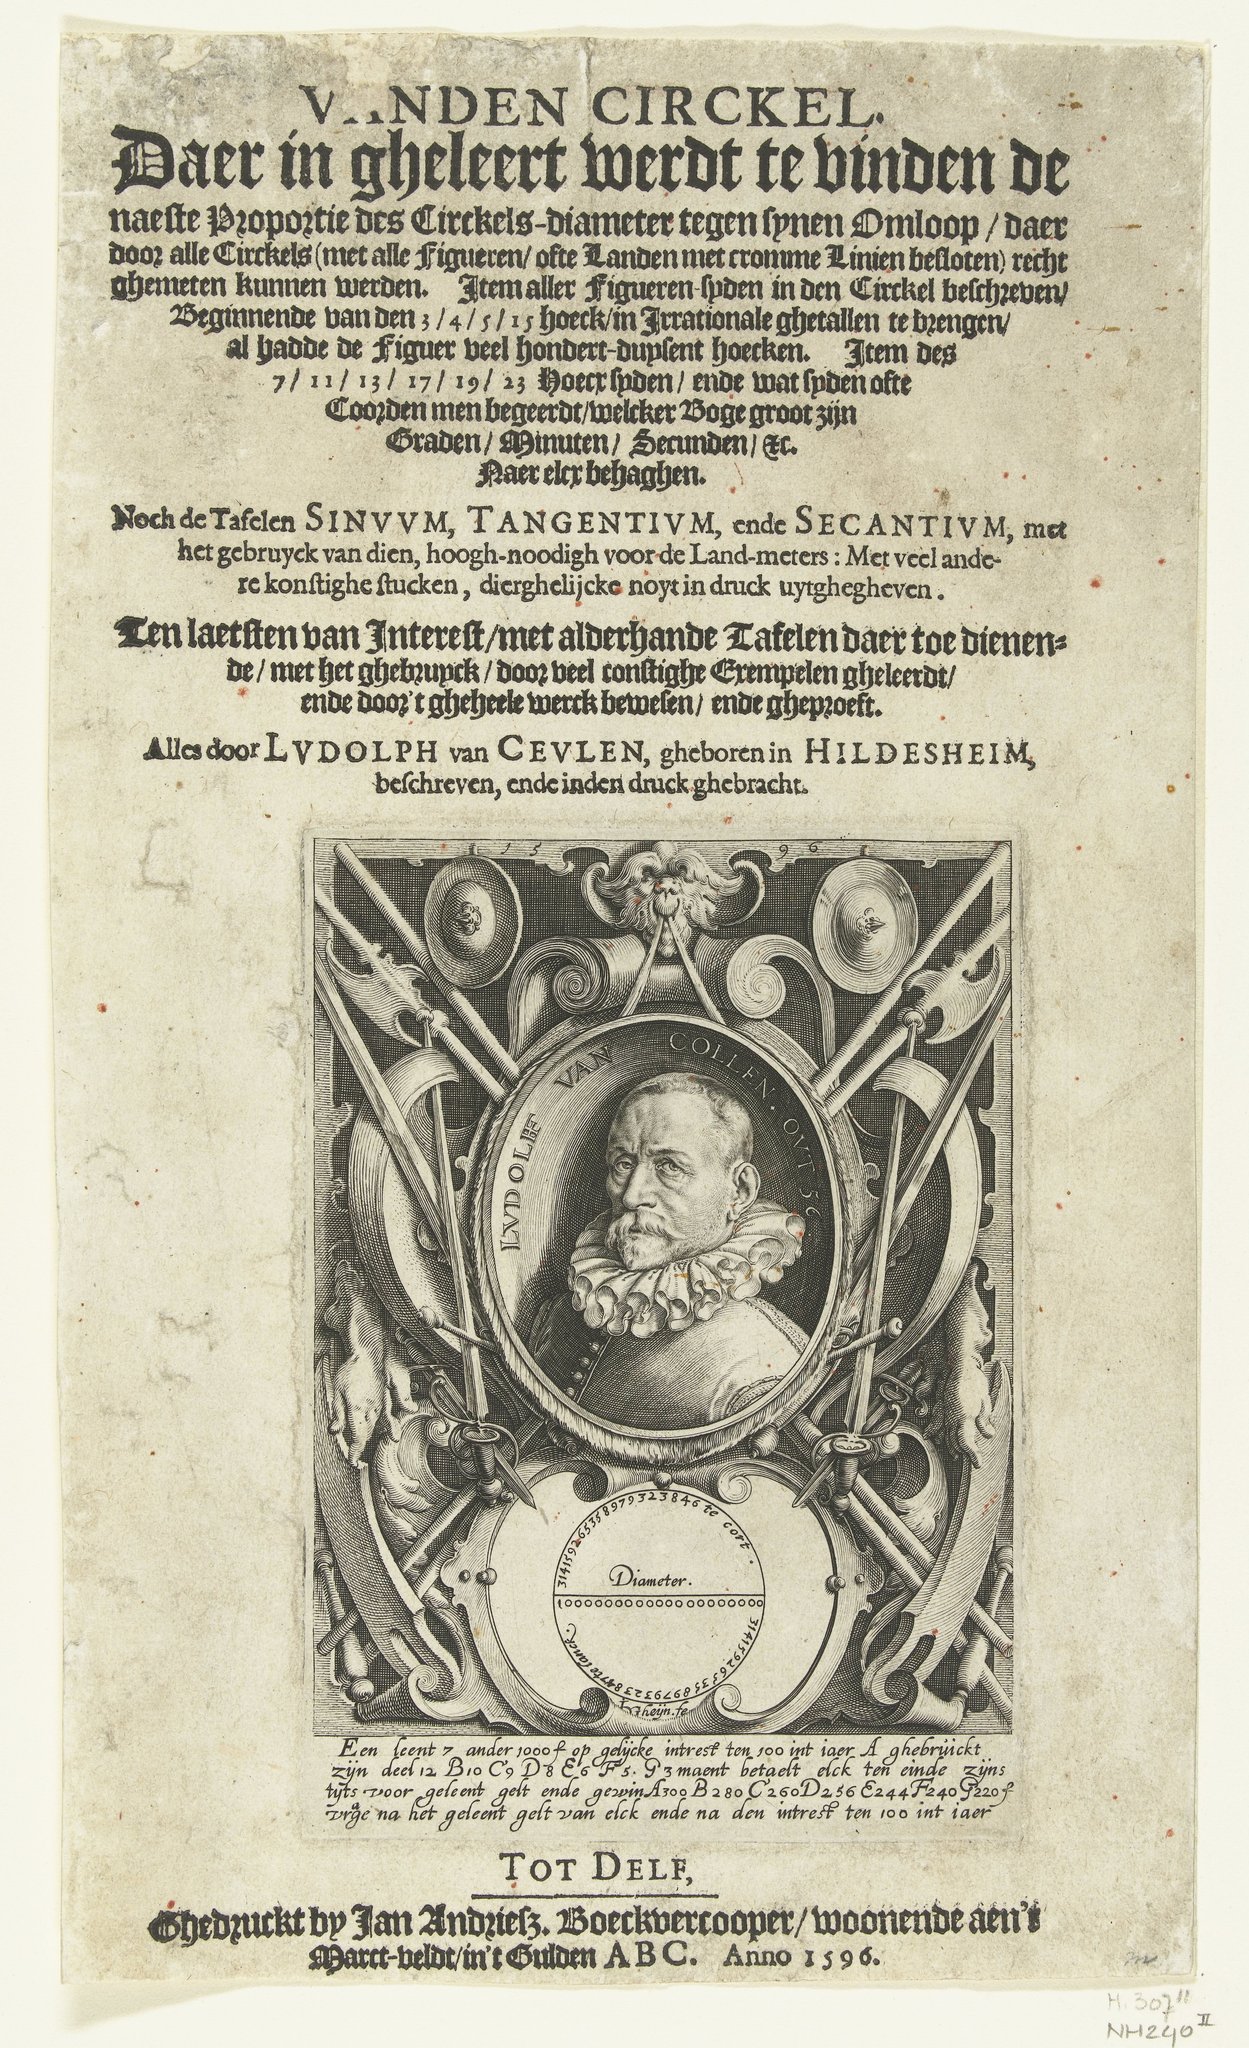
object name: print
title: Titelblad Ludolf van Ceulen, Vanden circkel (Delft 1596), met portret van Ludolf van Ceulen op 56-jarige leeftijd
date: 1596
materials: paper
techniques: engraving, letterpress printing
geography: leiden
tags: historical persons, mathematics (+ portrait of scholar, scientist)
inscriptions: collector's mark: Lugt 2228a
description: Titelblad Ludolf van Ceulen, Vanden circkel (Delft 1596). Buste van Ludolf van Ceulen (Hildesheim, 28 januari 1540 - Leiden, 31 december 1610) op 56-jarige leeftijd, met losgeplooide kraag, in ovaal met randschrift, gevat in ornamentlijst met rolwerk en wapens. Onder het portret een afbeelding van een cirkel met een beschrijving van het getal pi. Onder de voorstelling een vierregelig Nederlands onderschrift. Om de prent titelgegevens in boekdruk. Van Ceulen was schermer en mathematicus. Hij werd (volgens Meursius in 1599, volgens de resoluties van Curatoren op 10 januari 1600) op aanbeveling van prins Maurits samen met Simon Fransz. van Merwen benoemd tot professor in de 'Nederduytsche mathematicque' in Leiden. Berekende het getal pi (de verhouding tussen de omtrek en de middellijn van een cirkel) in 35 decimalen.